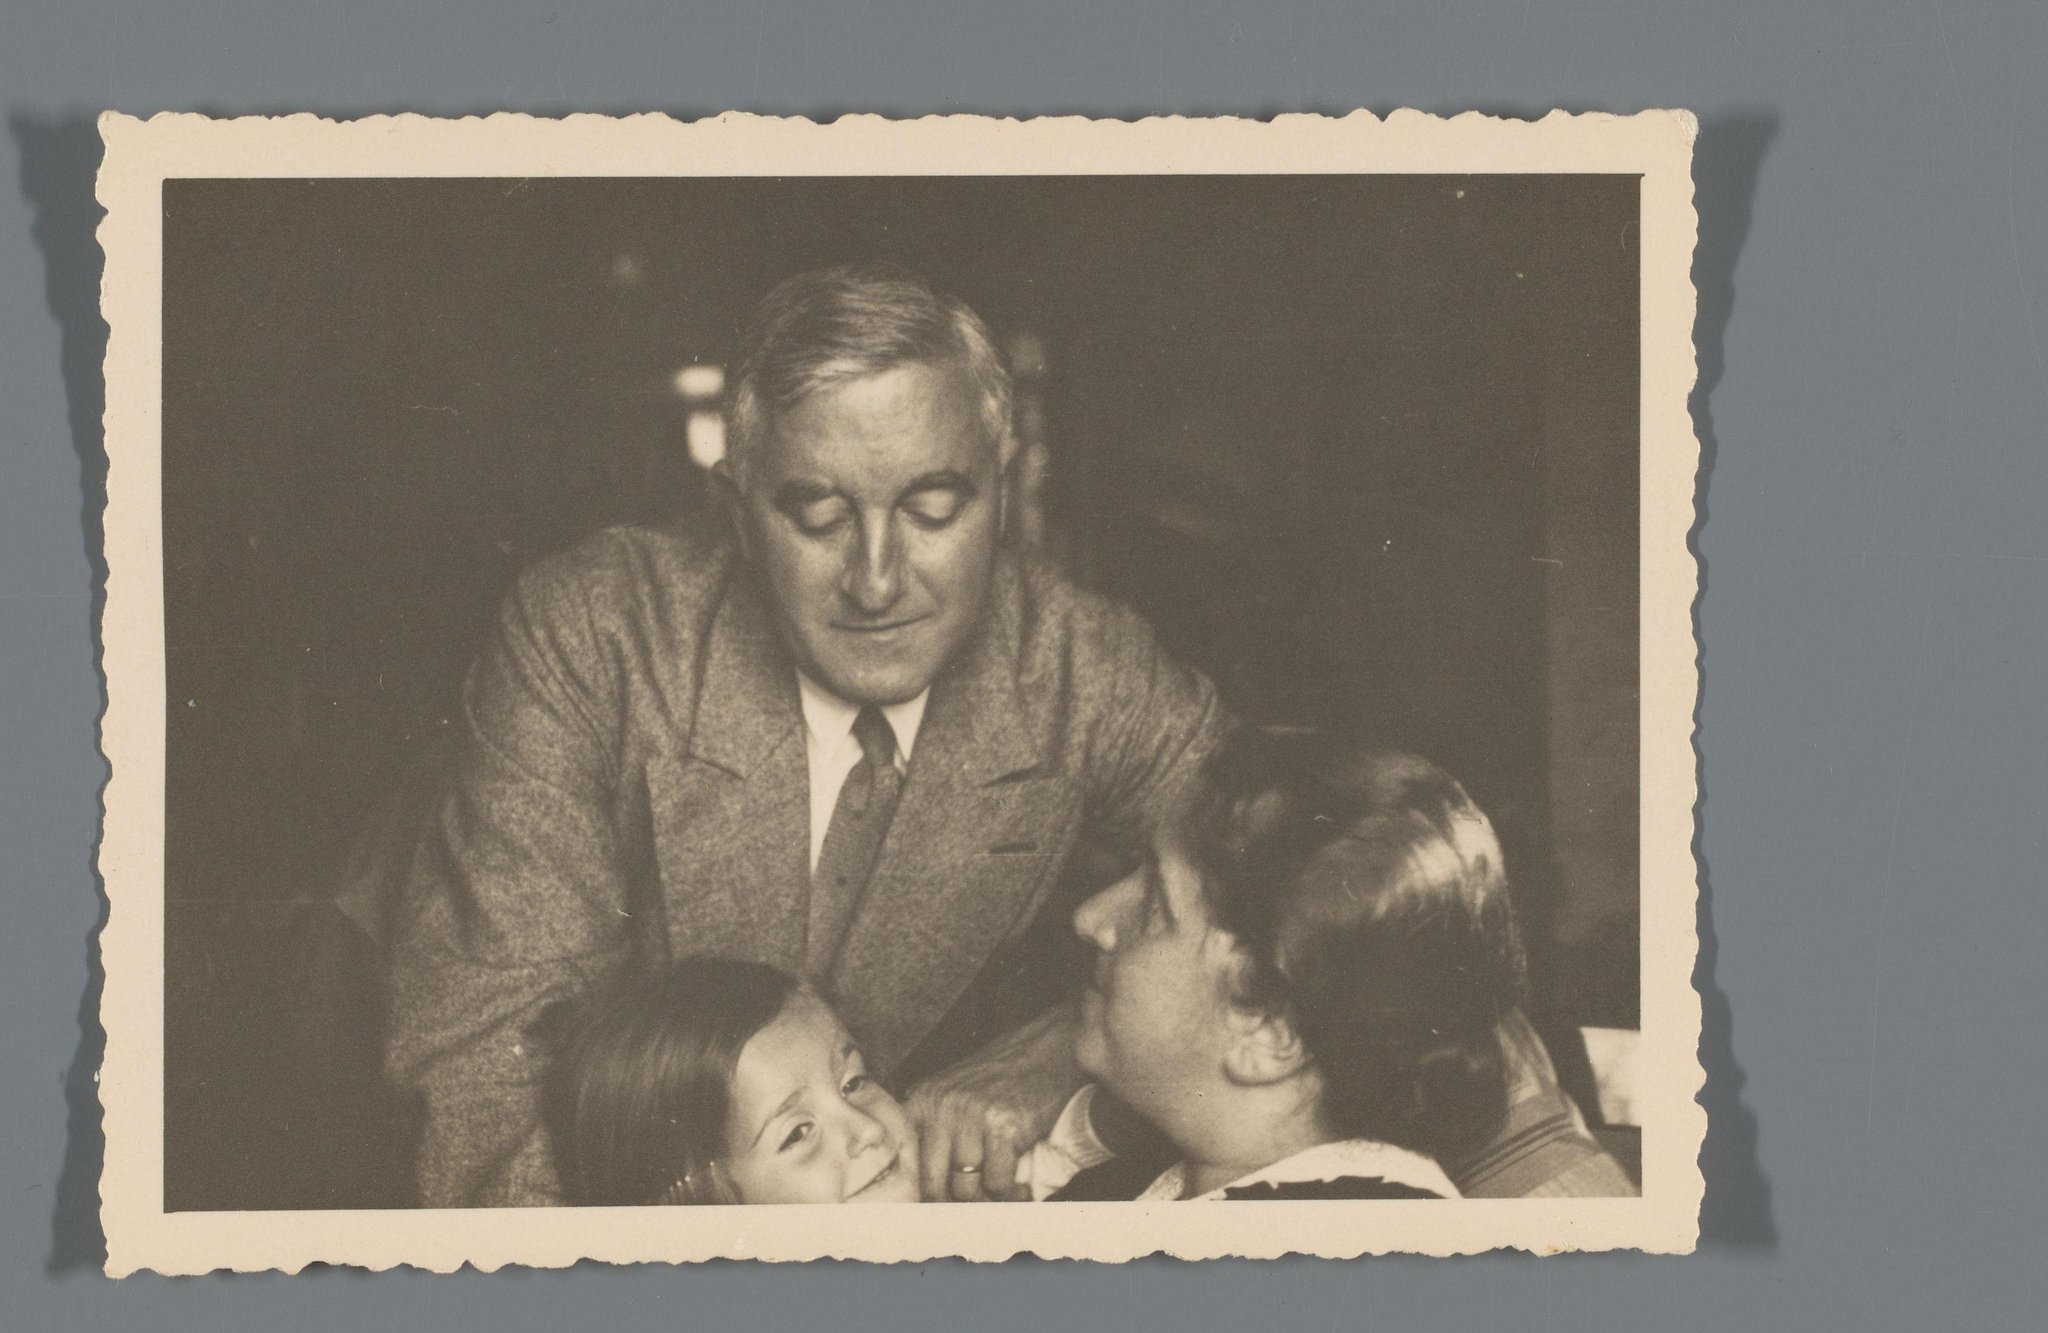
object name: photograph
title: Eugen Wachenheimer die neerkijkt op zijn echtgenote Else Wachenheimer-Moos en hun dochter Isabel Wachenheimer, met Else die terugkijkt naar Eugen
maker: Anonymous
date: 1910-1932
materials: photographic support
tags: eugen wachenheimer, else wachenheimer-moos, leiden, isabel wachenheimer-elon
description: Eugen Wachenheimer (achter) die neerkijkt op zijn echtgenote Else Wachenheimer-Moos (voor, rechts) en hun dochter Isabel Wachenheimer (voor, links), met Else die terugkijkt naar Eugen.